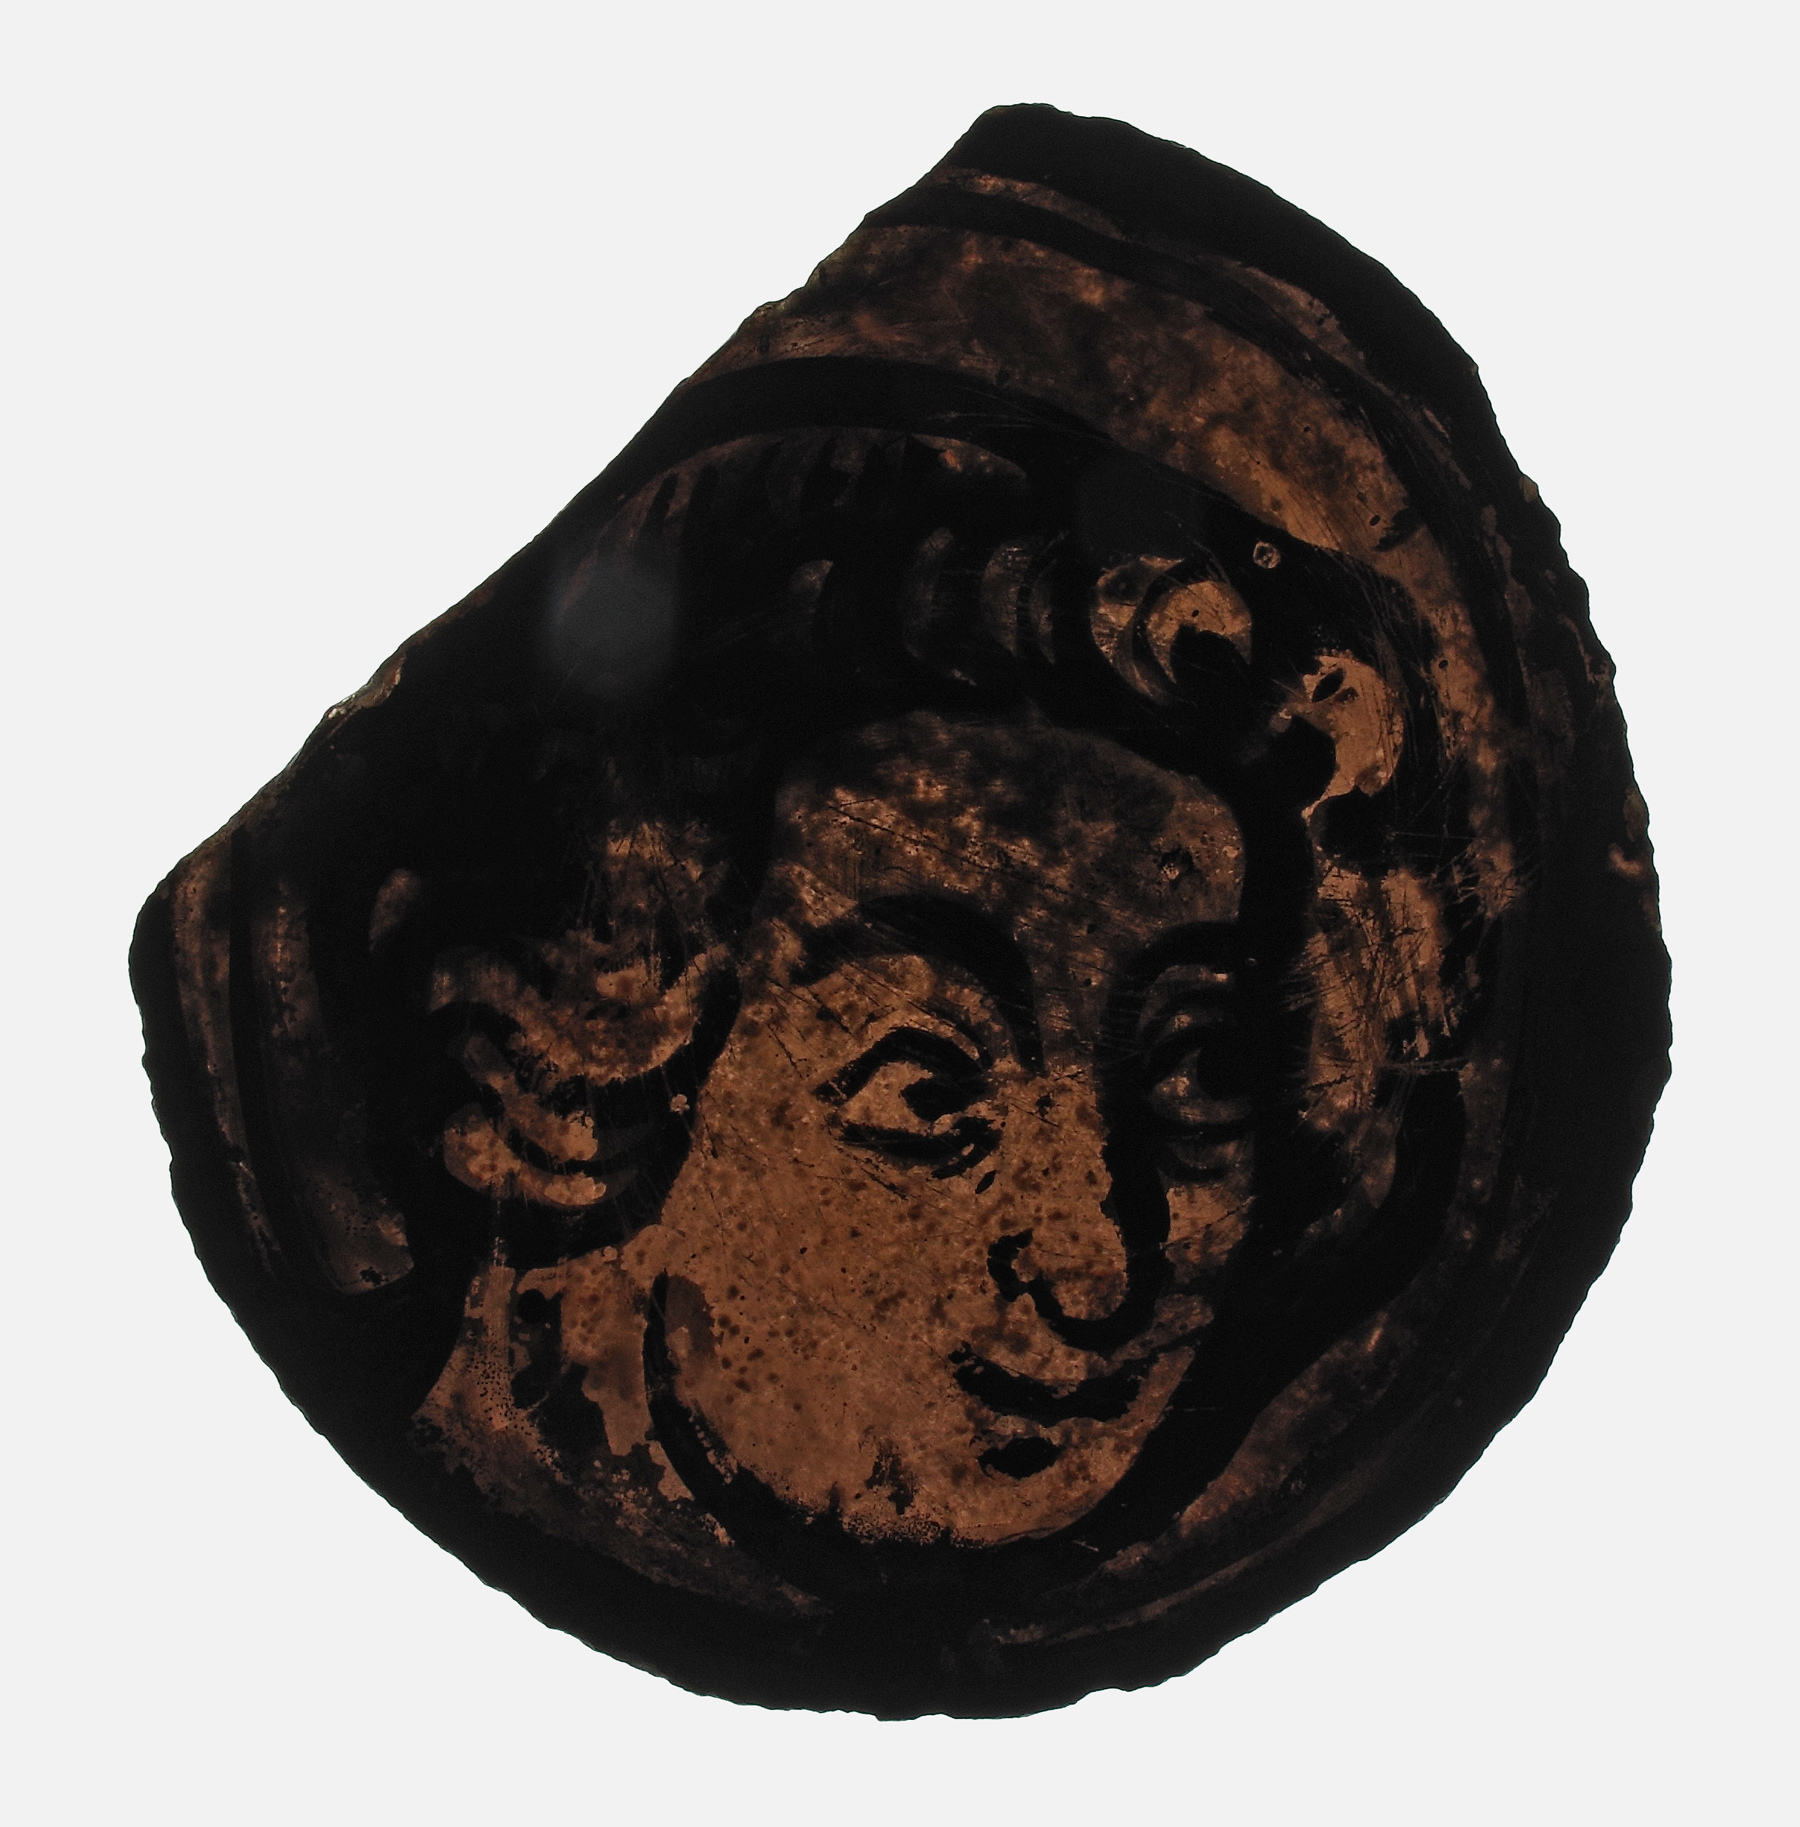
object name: fragment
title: Glass Fragment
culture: european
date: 1245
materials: glass, metal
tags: human figures